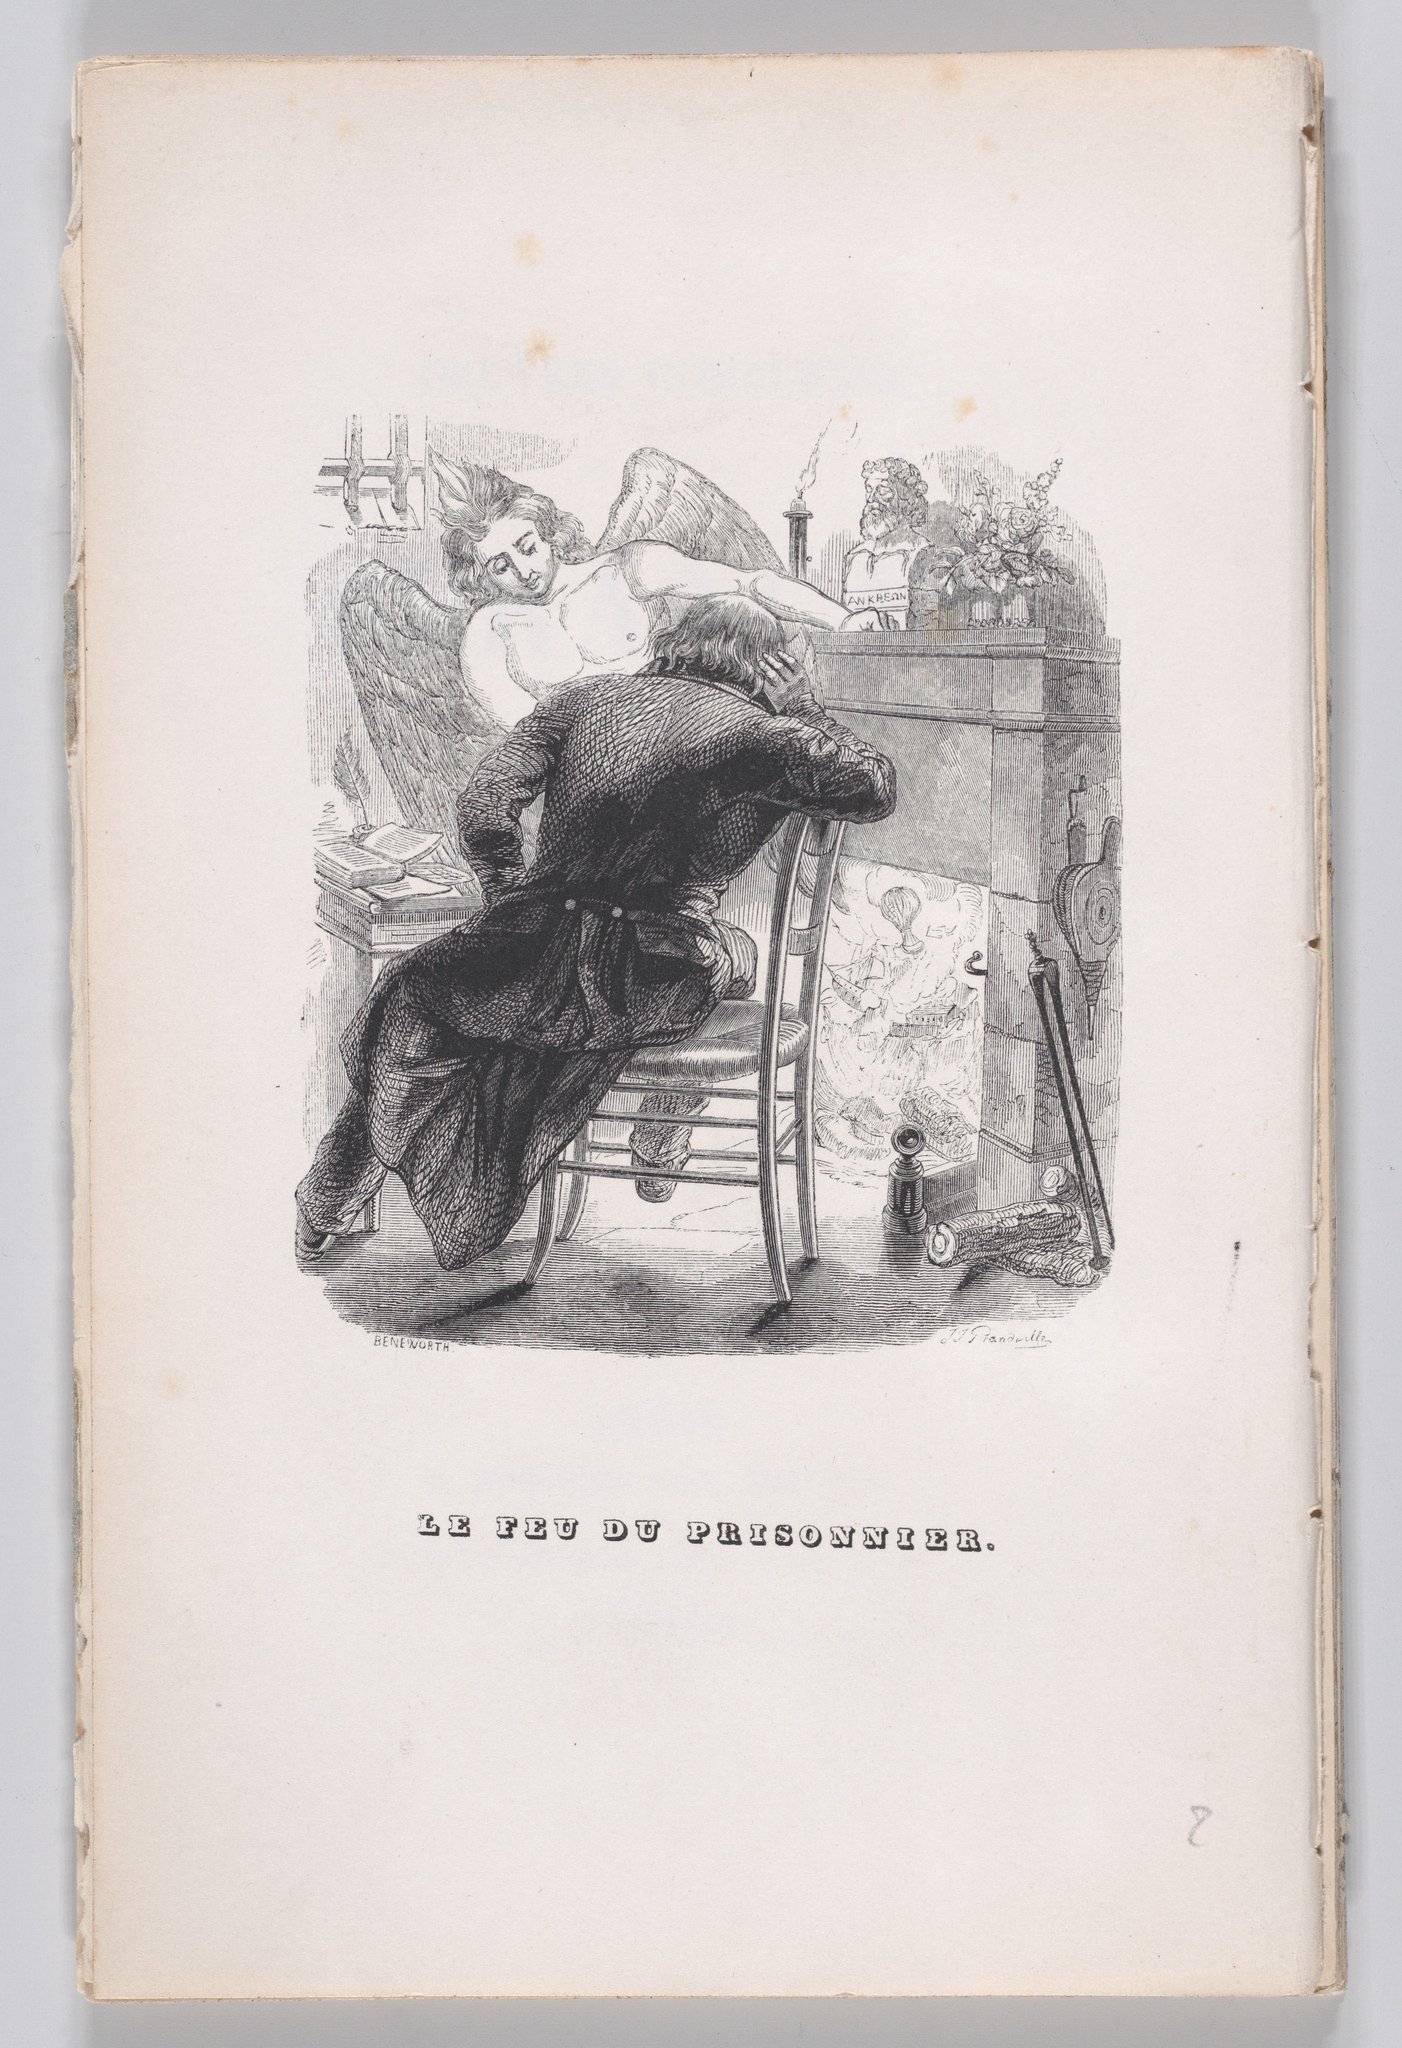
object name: print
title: The Prisoner's Fire, from "The Complete Works of Béranger"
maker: j. j. grandville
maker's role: illustrator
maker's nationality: french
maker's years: 1803-1847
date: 1836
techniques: engraving